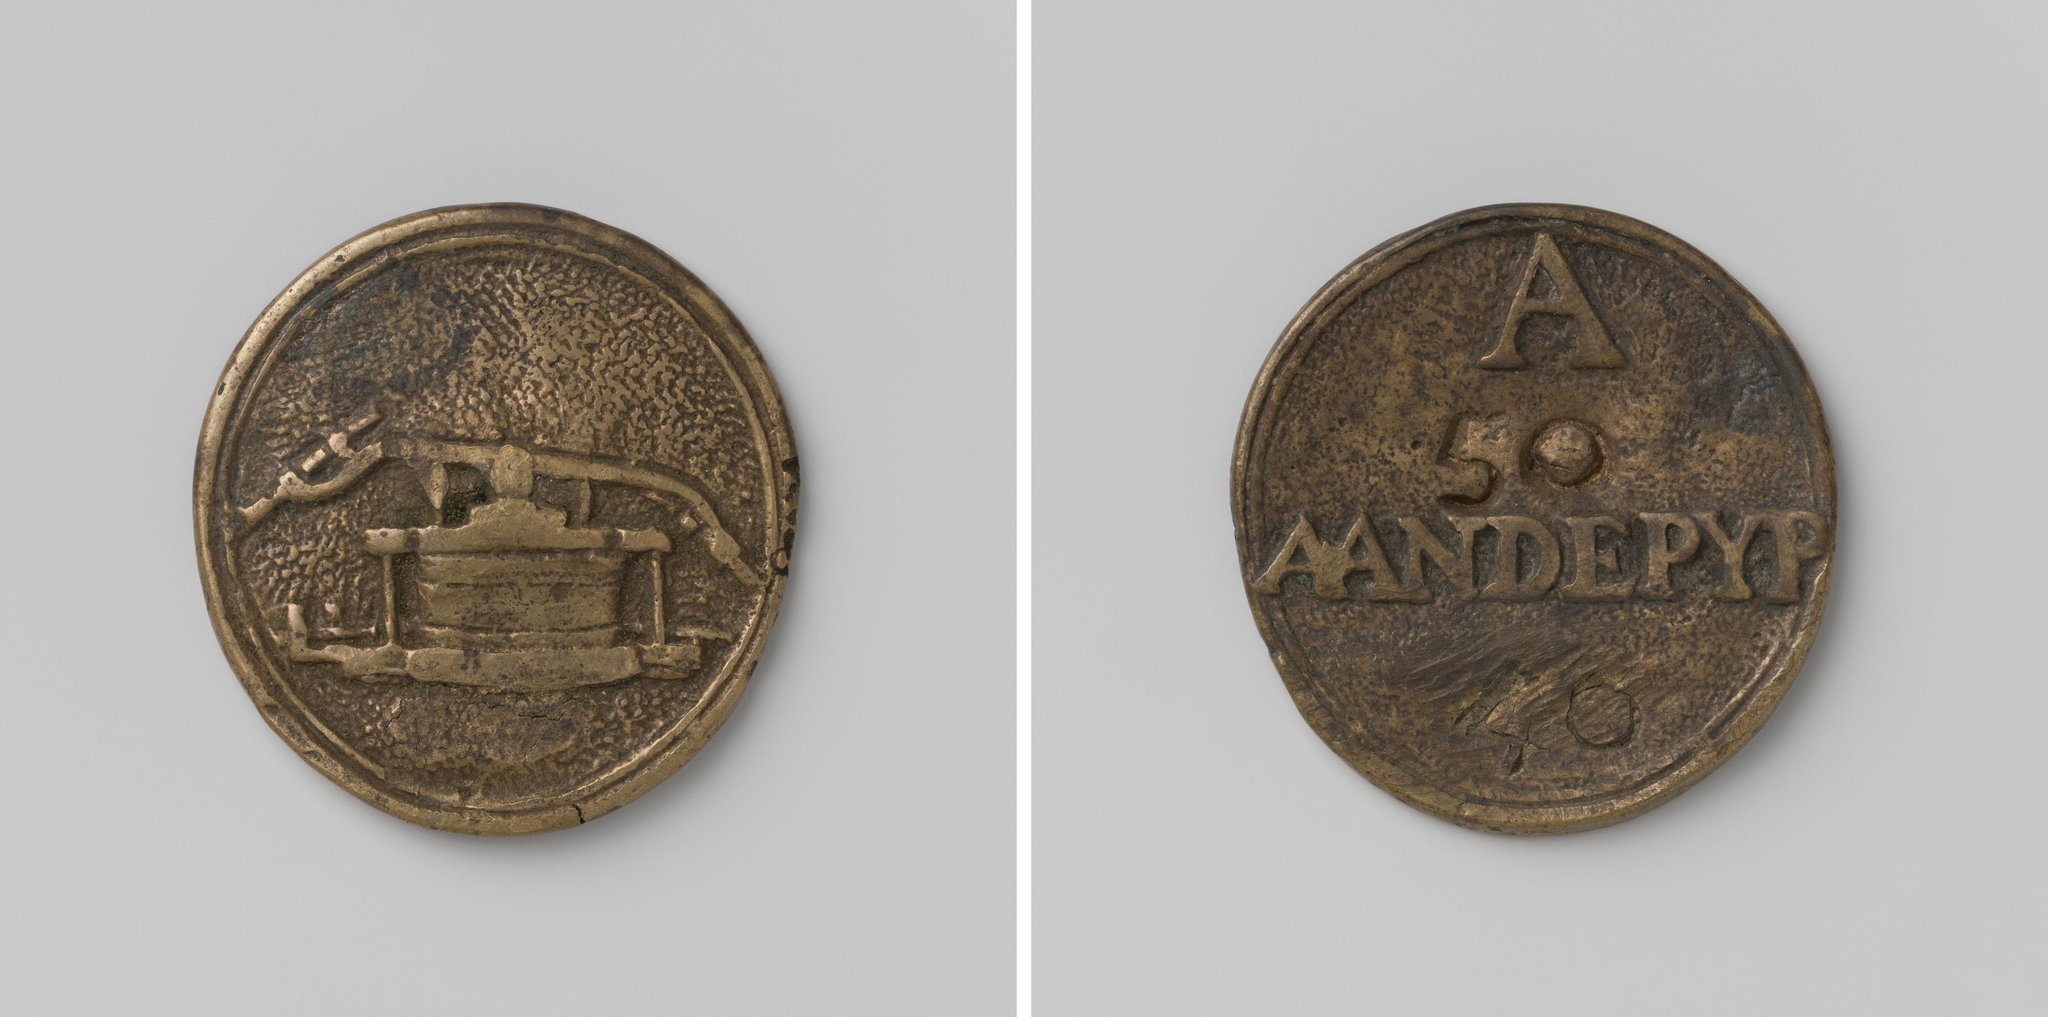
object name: medal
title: Enkhuizen, brandspuitpenning van de man aan de zuigpijp van spuit A met no. 50 en no. 40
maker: Anonymous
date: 1680-1800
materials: brass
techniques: casting, engraving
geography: enkhuizen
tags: enkhuizen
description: Messing penning. Voorzijde: brandspuit. Keerzijde: opschrift boven cijfer 50 en gedeeltelijk uitgewist cijfer 40